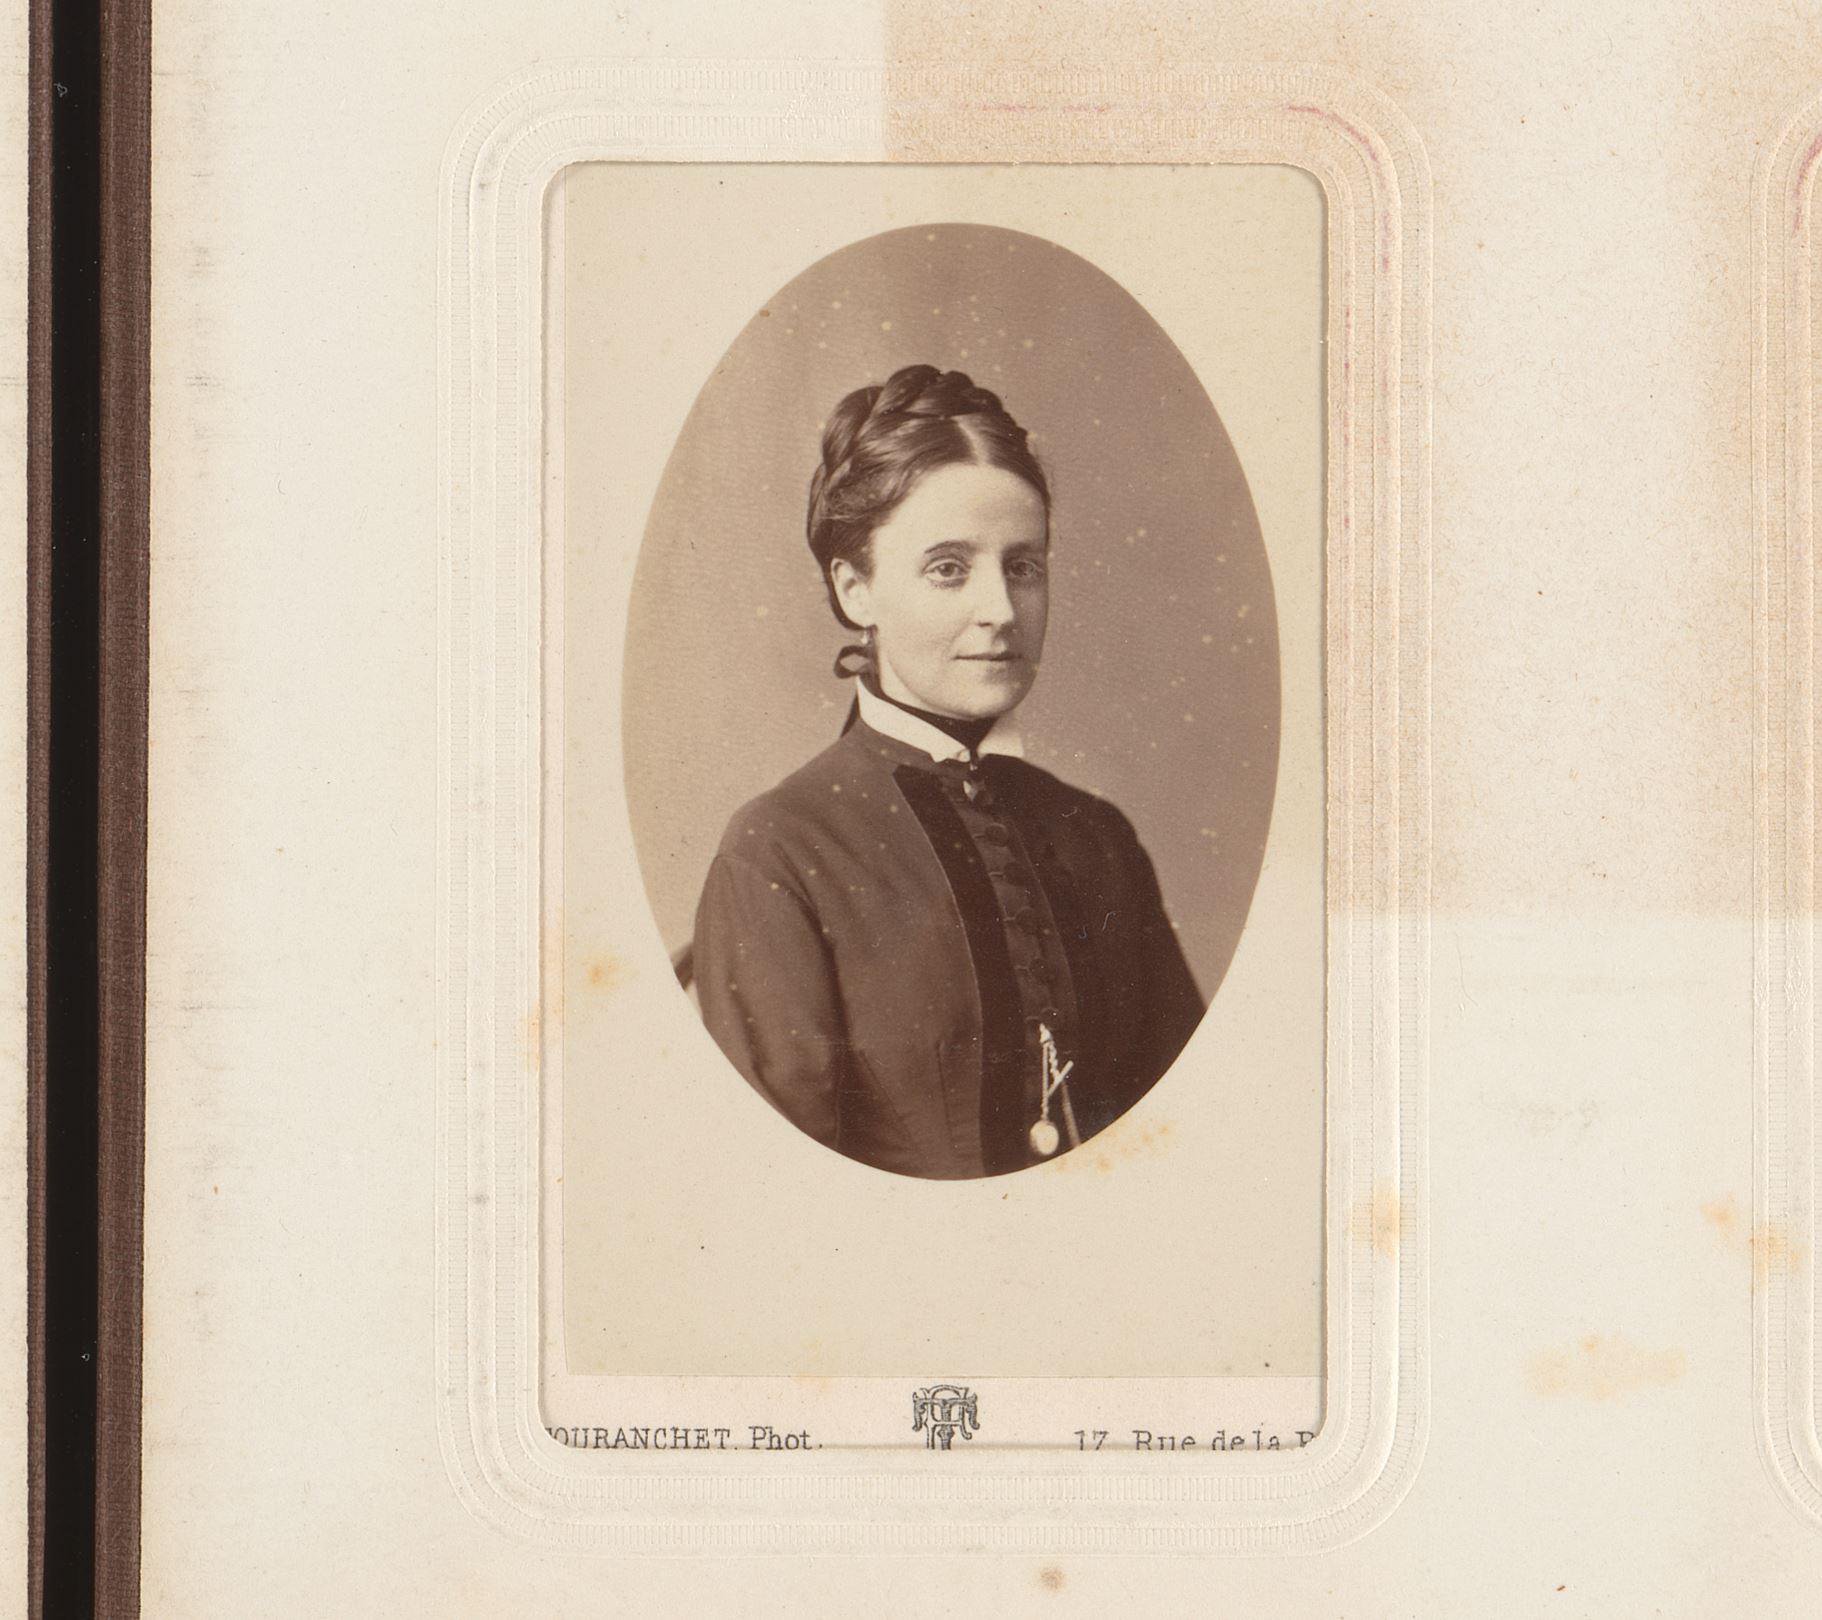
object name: photograph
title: Portret van een vrouw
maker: françois touranchet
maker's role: fotograaf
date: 1900-1968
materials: cardboard, paper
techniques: albumen print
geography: paris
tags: historical persons - bb - woman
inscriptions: inscription: ‘TOURANCHET. Phot. FT 17, Rue de la Paix’